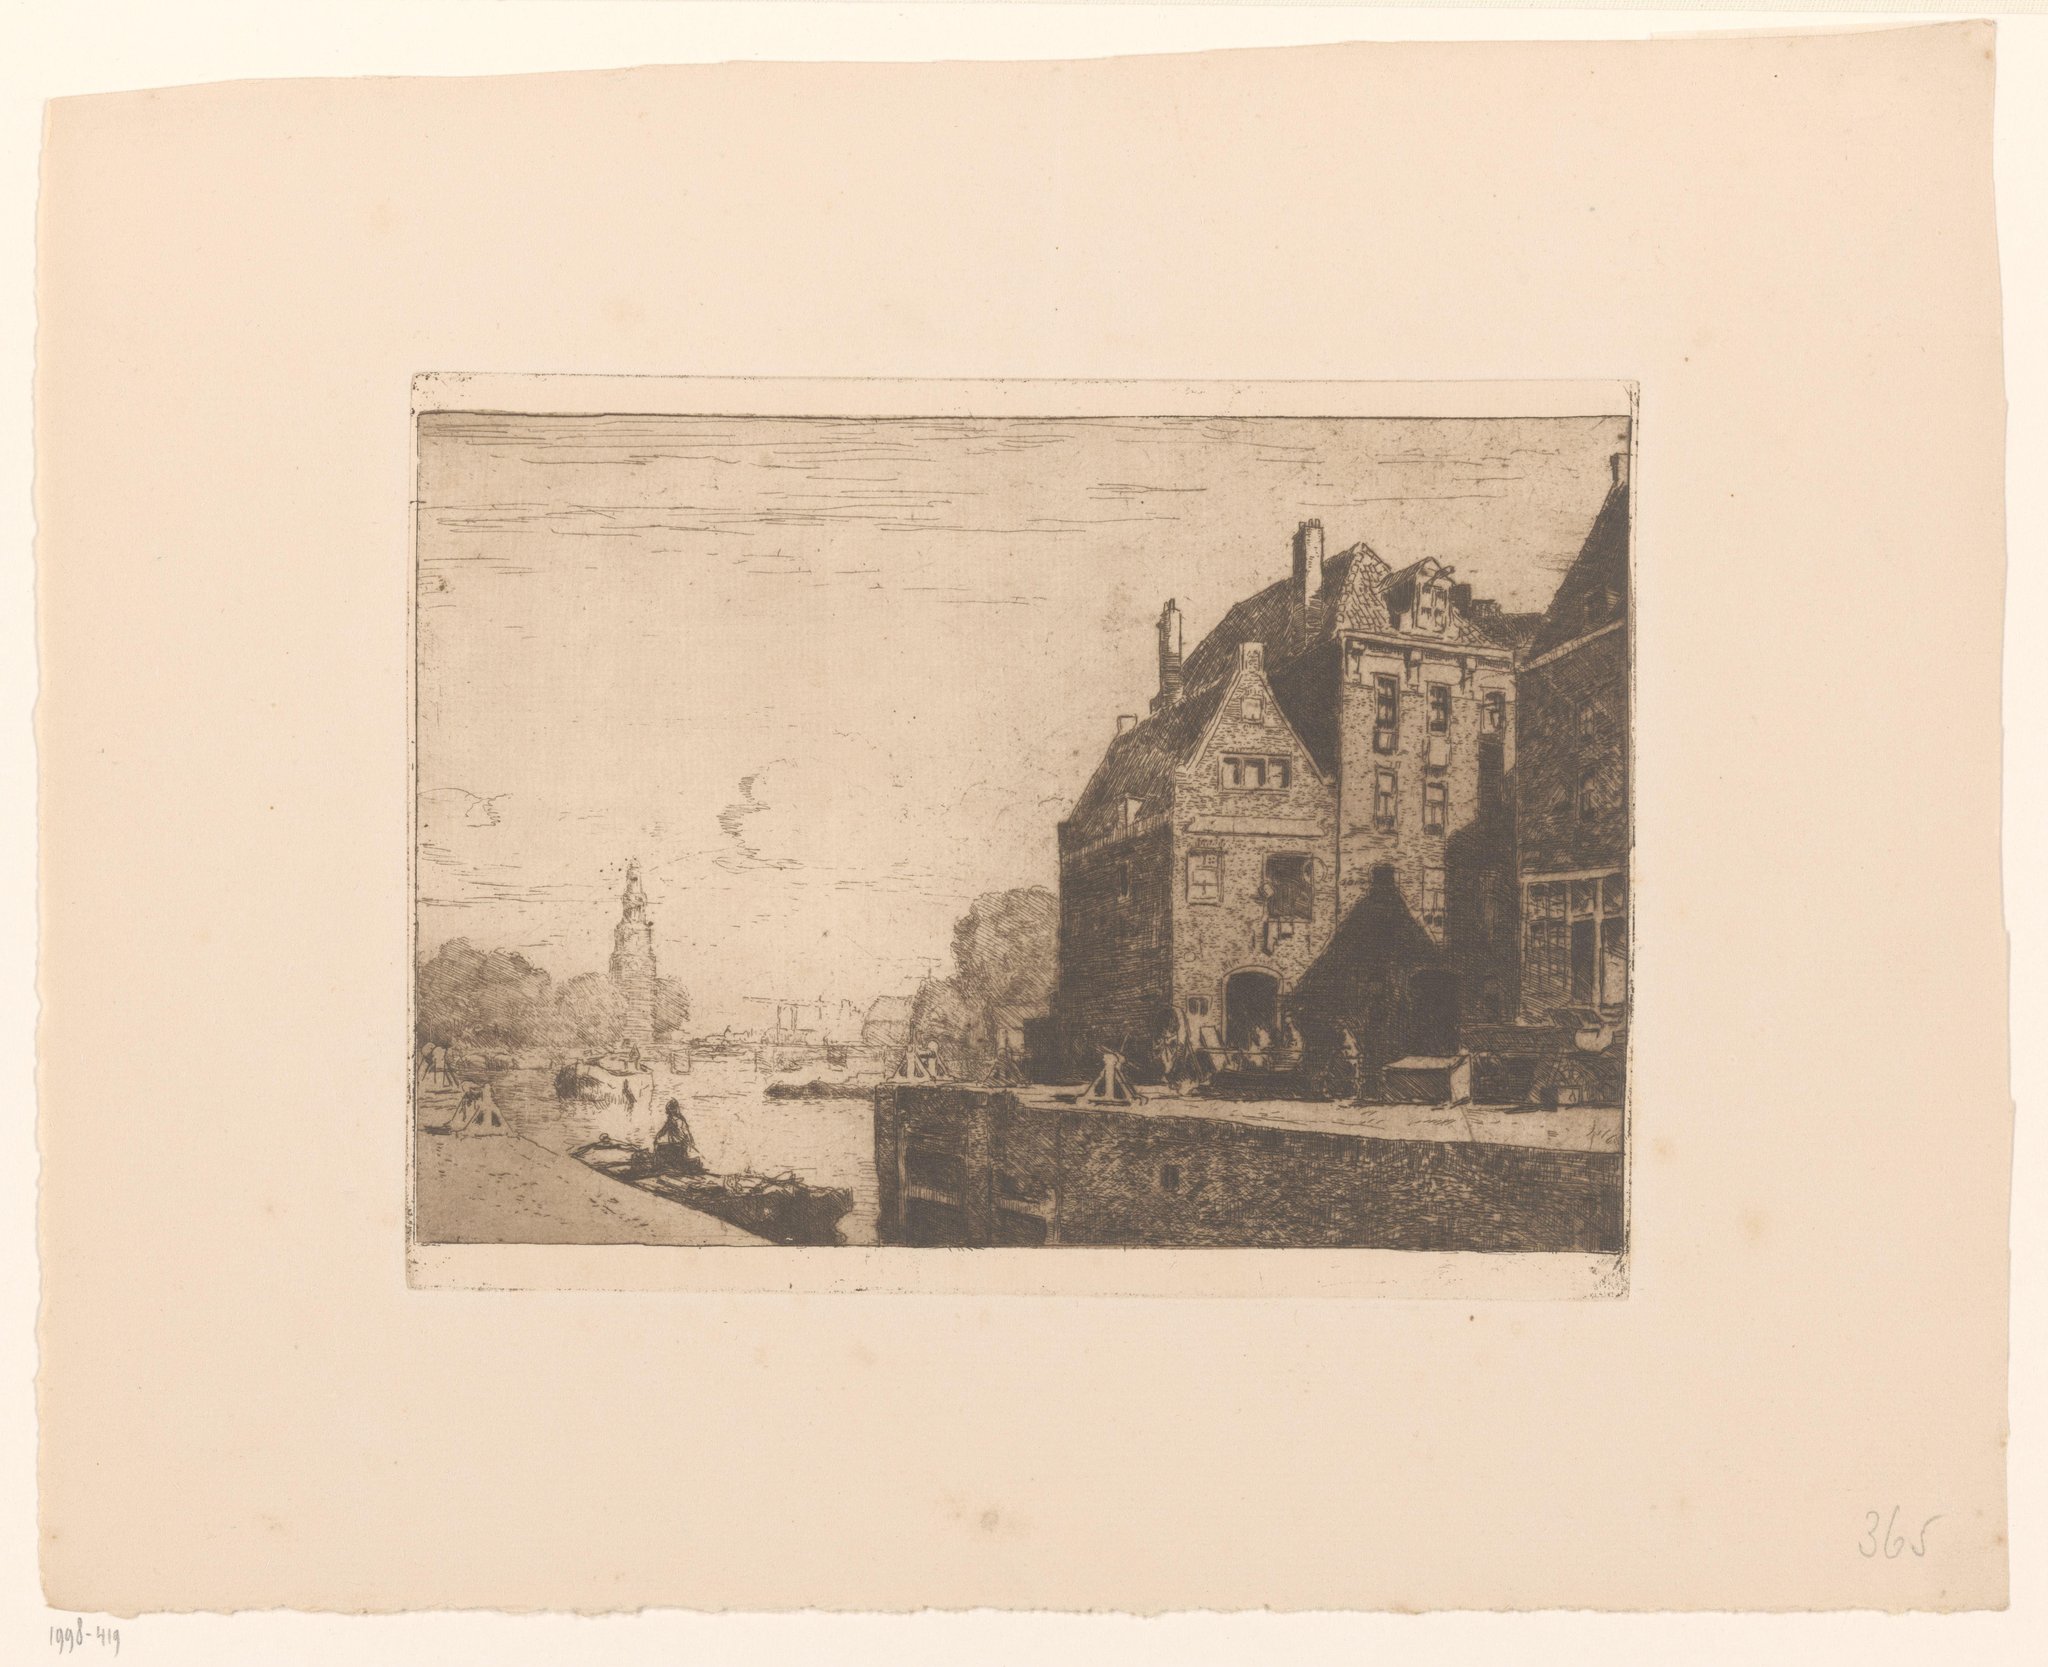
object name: print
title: Sint Antoniesluis, Amsterdam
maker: cornelis vreedenburgh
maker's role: draughtsman, print maker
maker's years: 1880-1946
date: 1890-1946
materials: paper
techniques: etching, intaglio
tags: lift-lock, canal lock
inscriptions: collector's mark: Lugt 2228, collector's mark: Lugt 2760